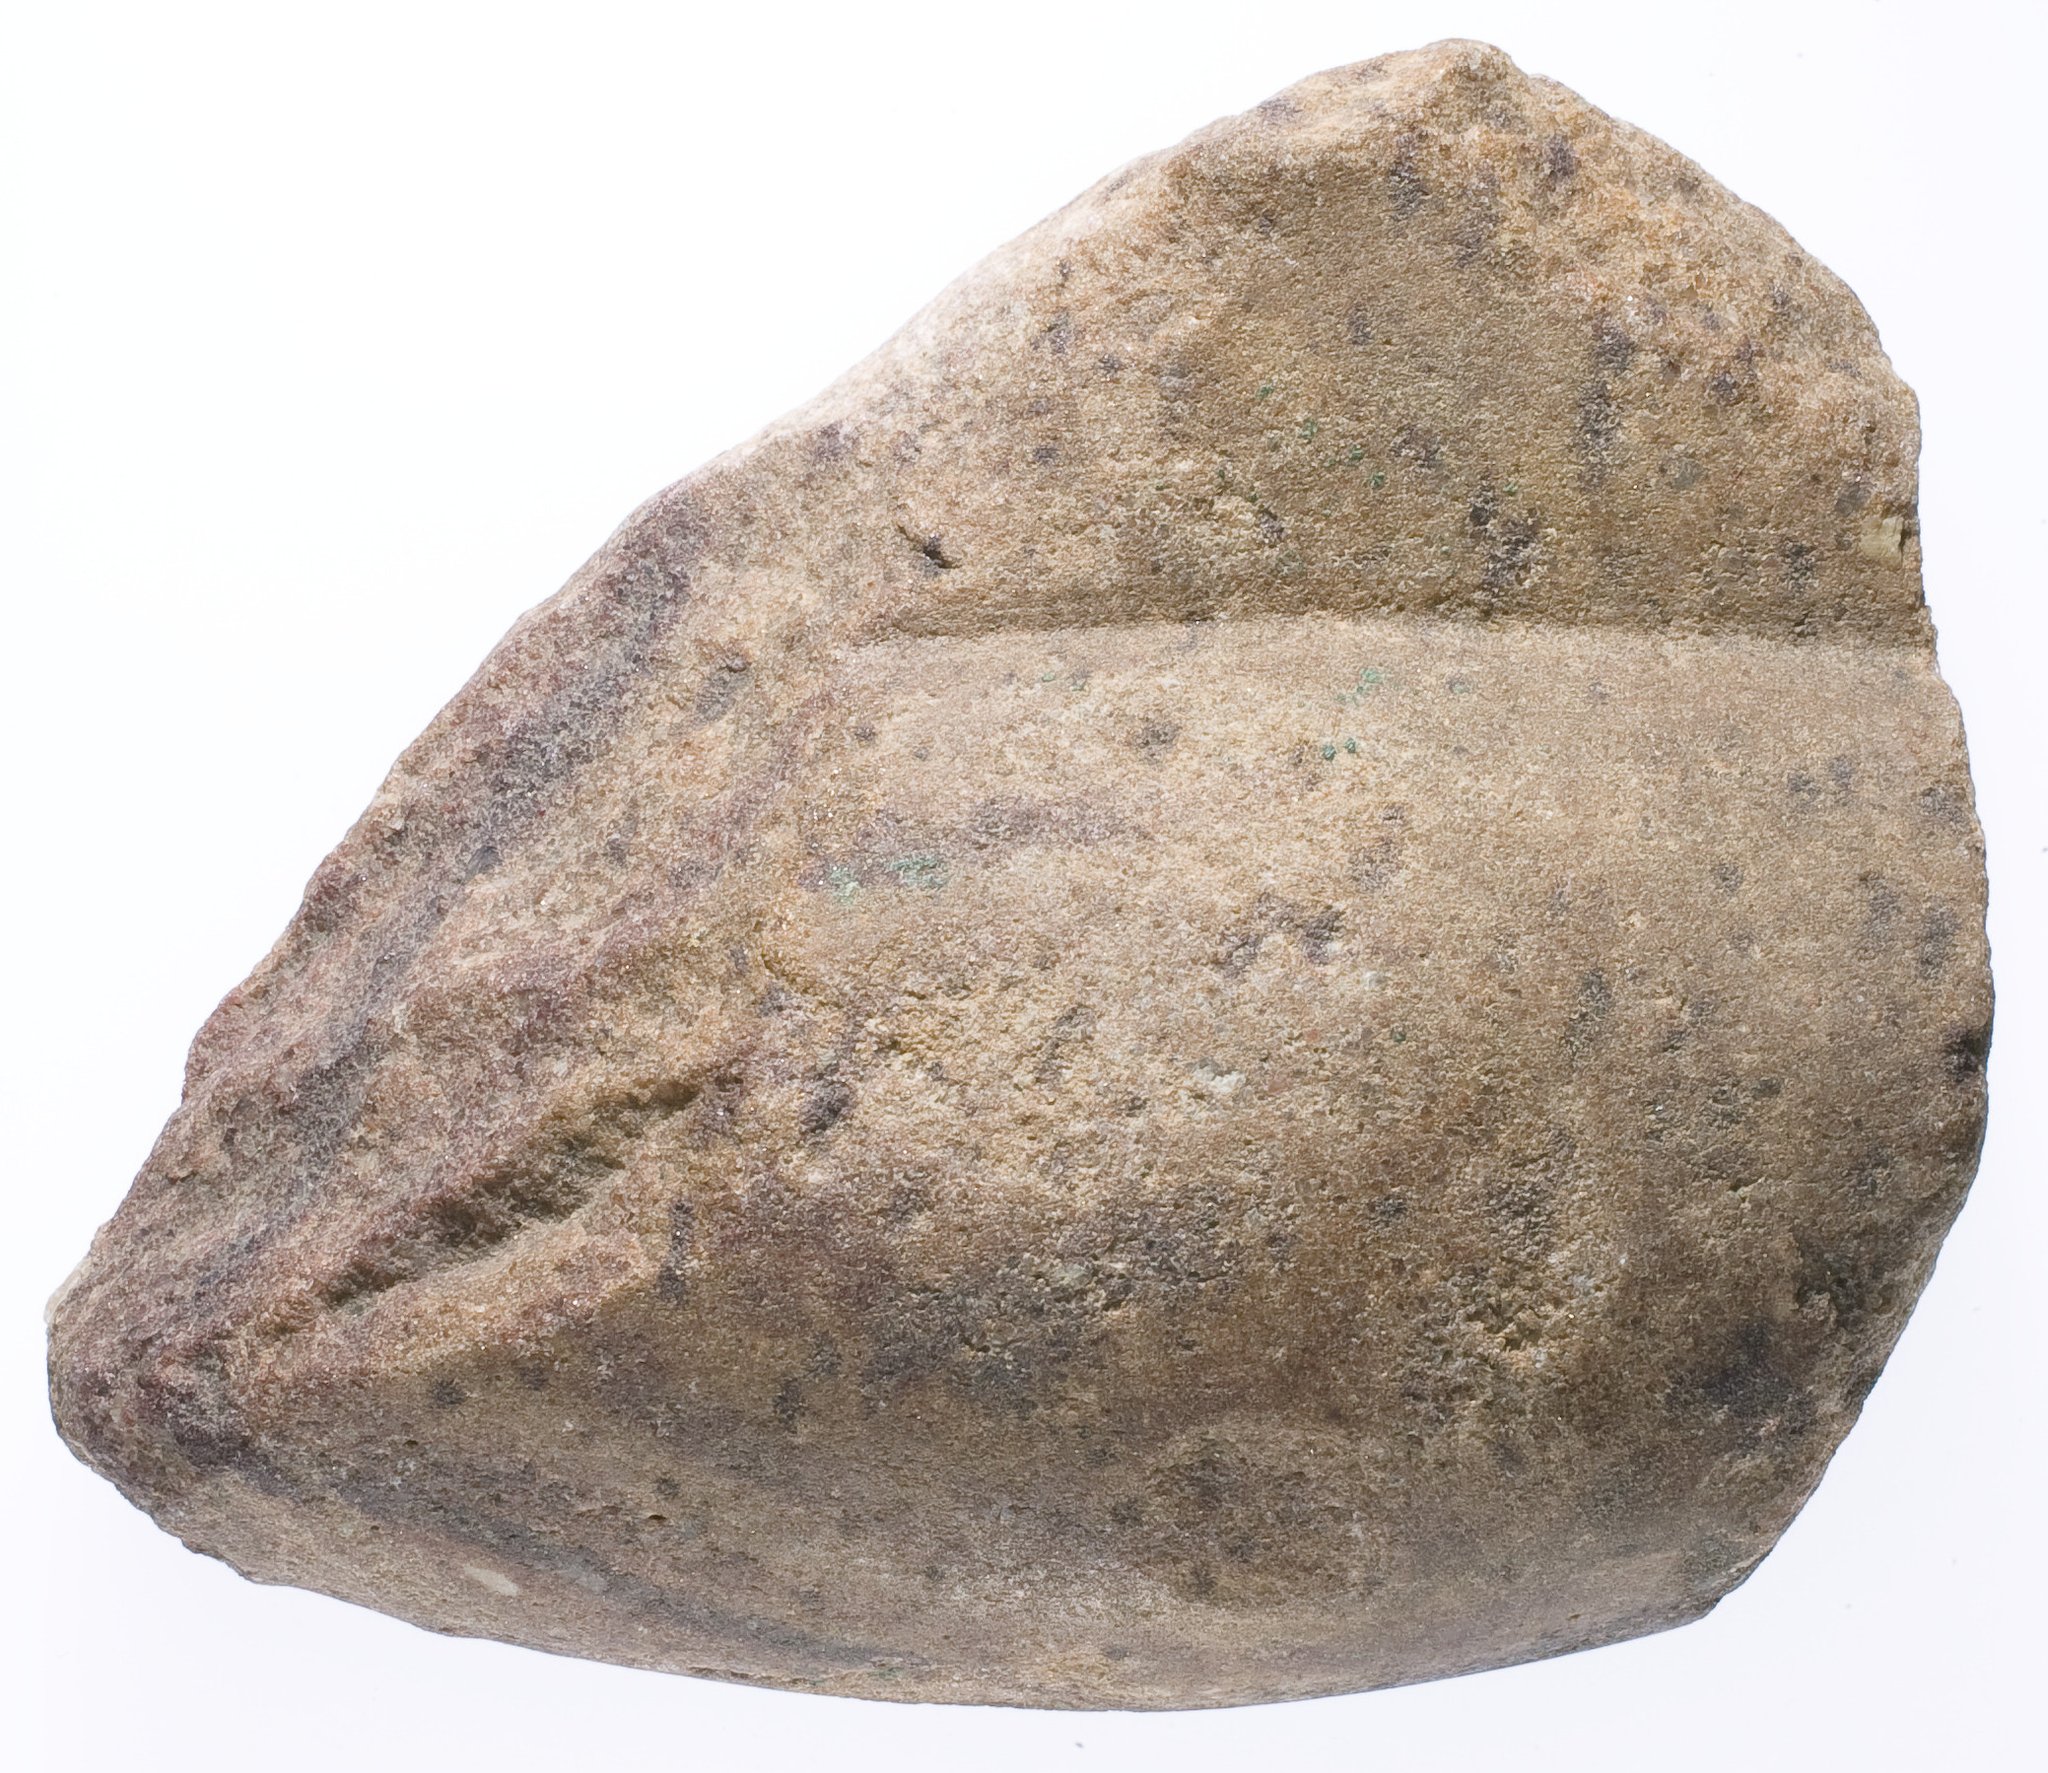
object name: right elbow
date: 1353-1336 BCE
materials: quartzite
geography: egypt